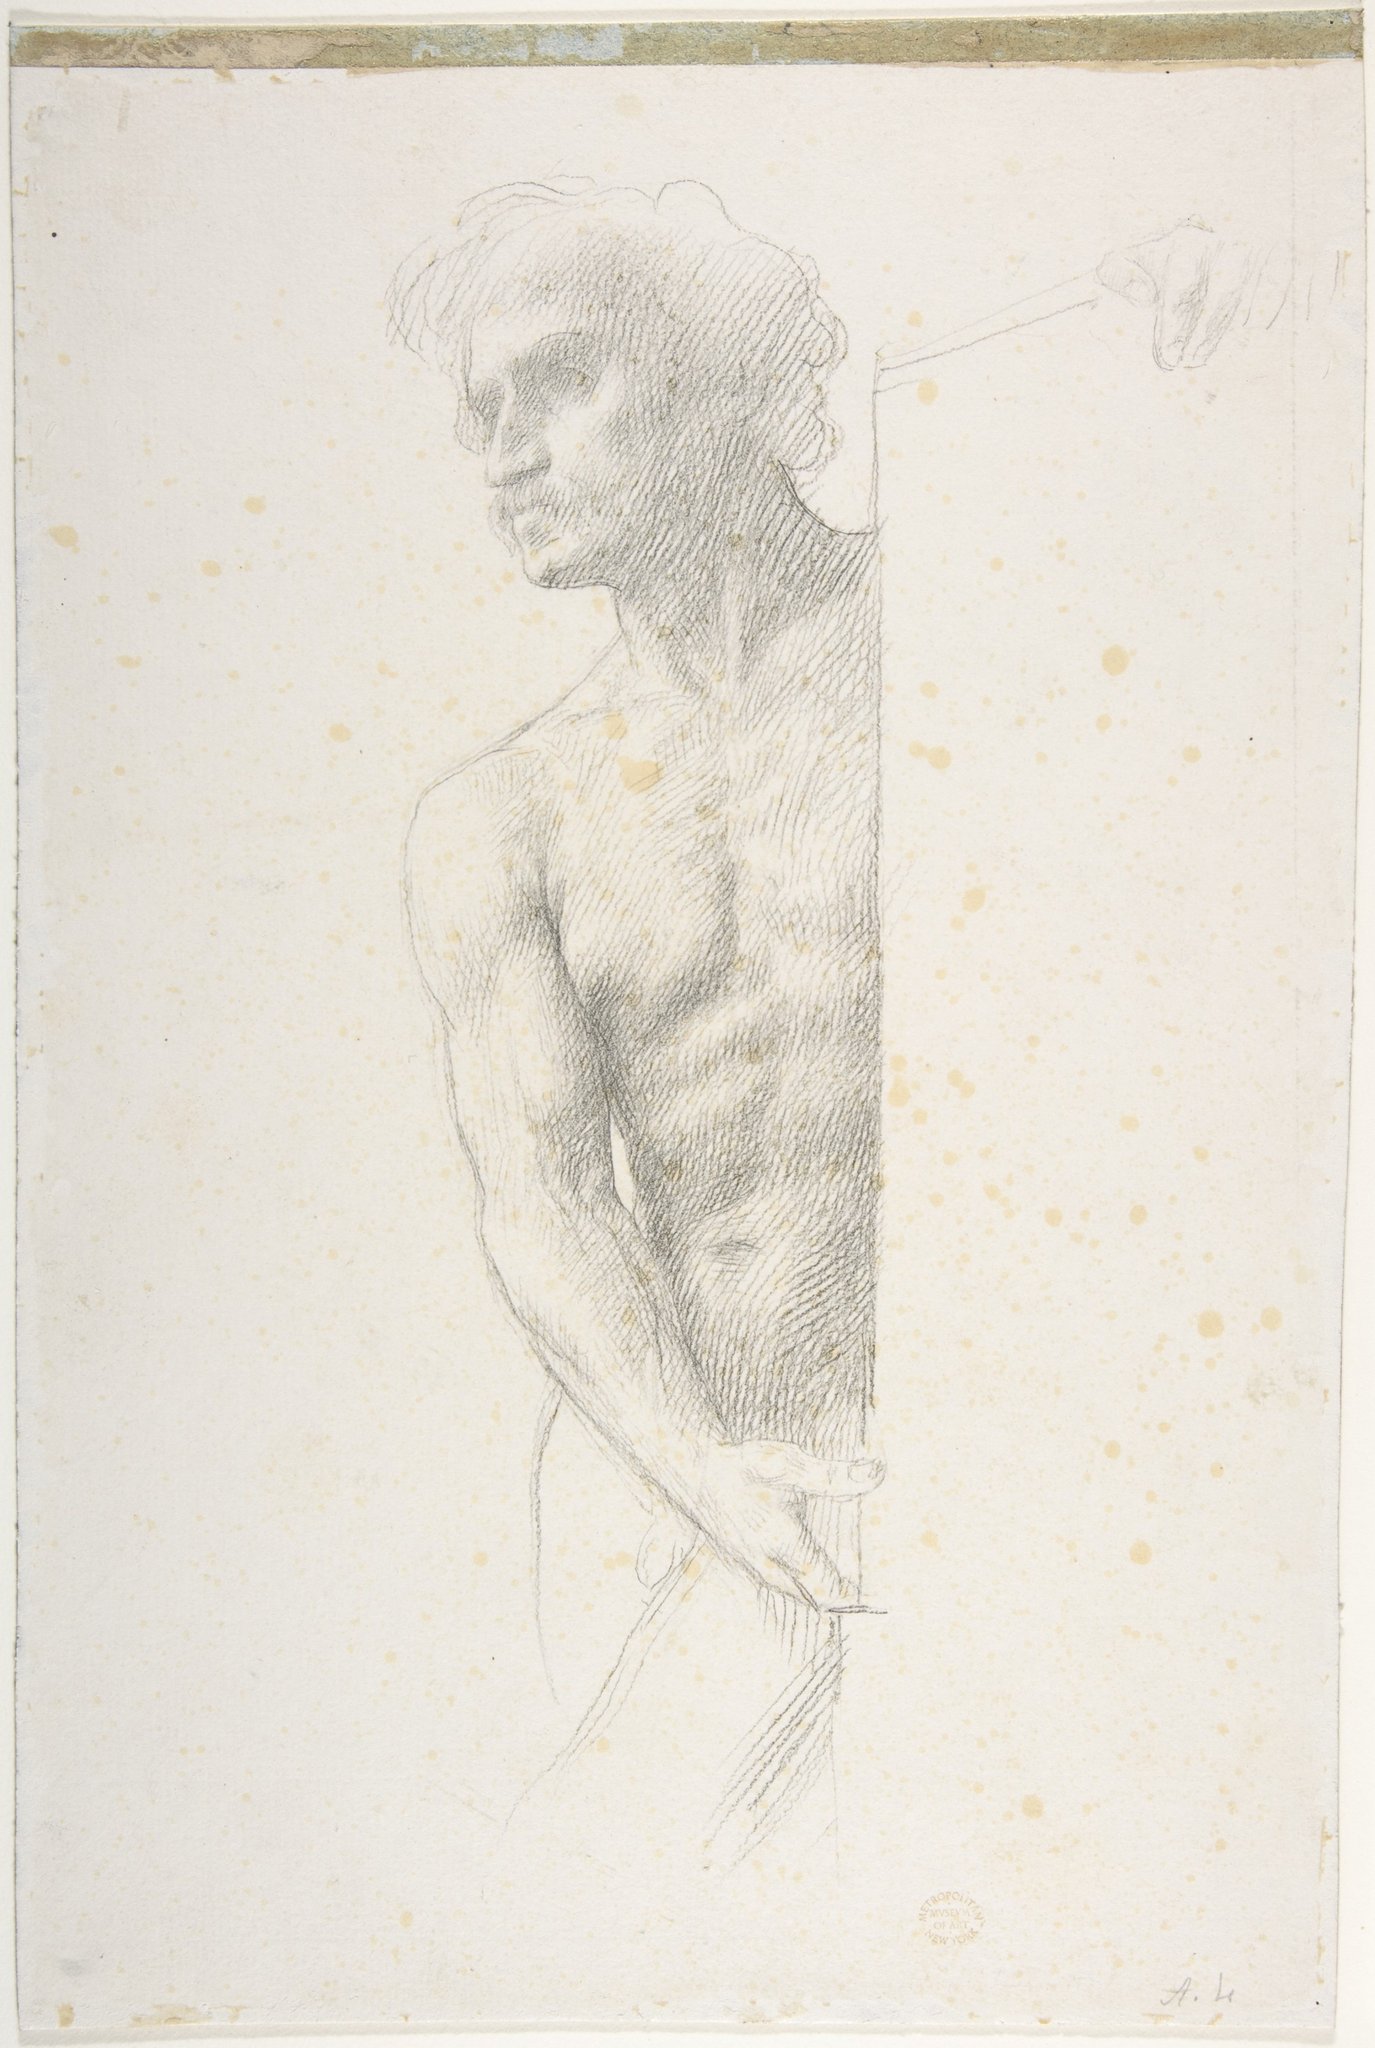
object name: drawing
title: Study of a Figure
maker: alphonse legros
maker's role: artist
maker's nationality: french and british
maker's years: 1837-1911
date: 1837-1911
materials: chalk, paper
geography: france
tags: male nudes